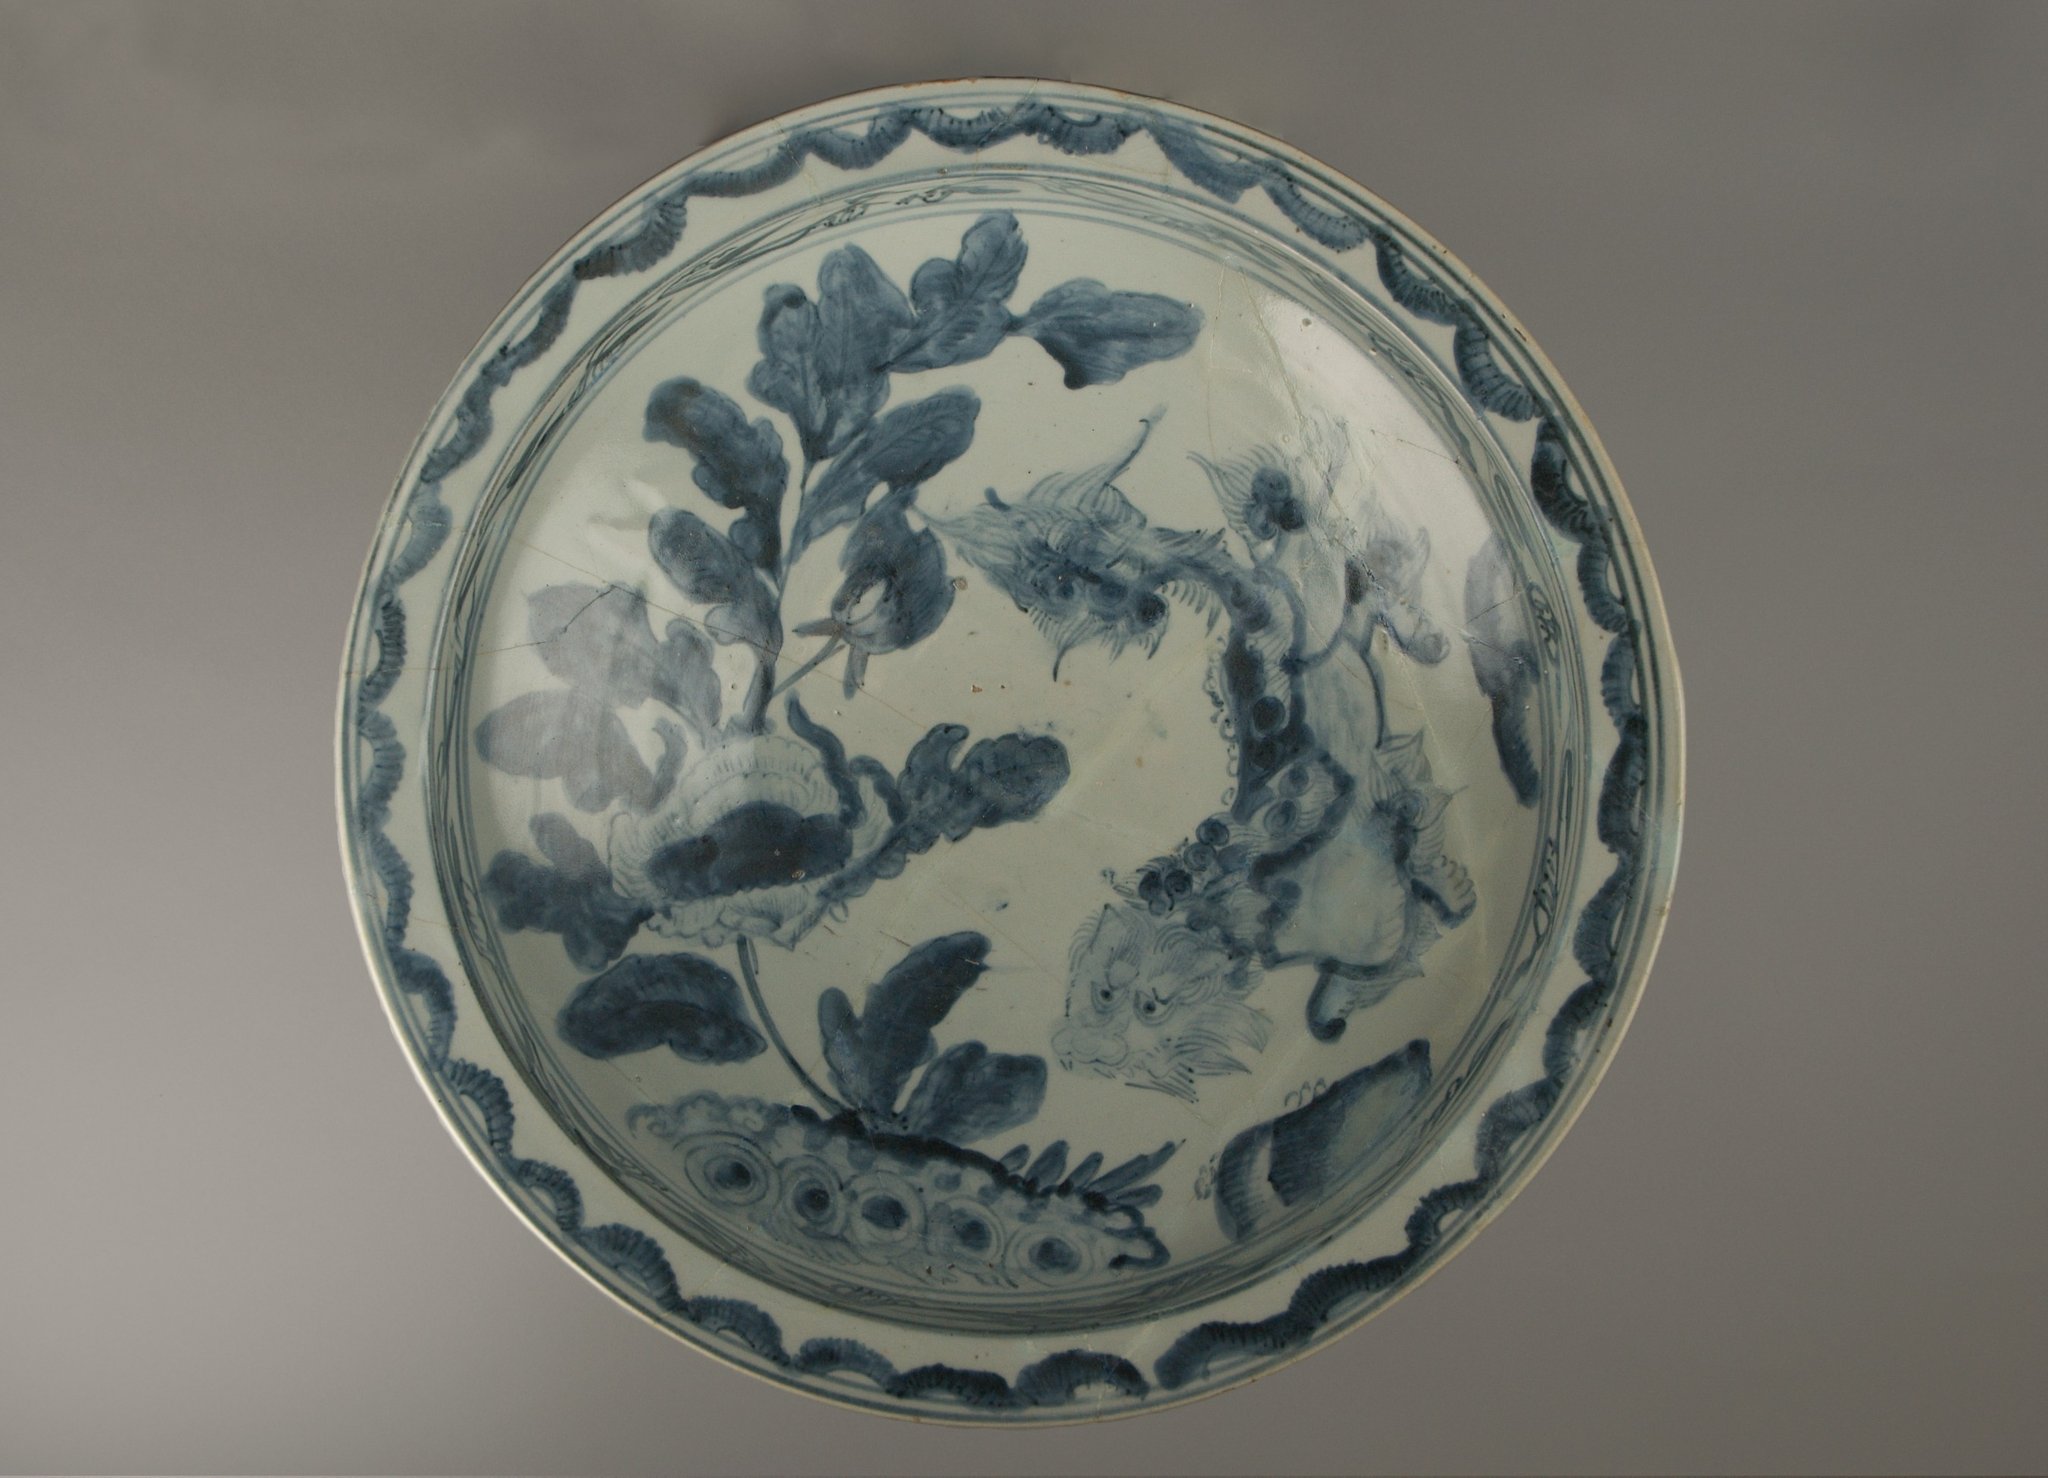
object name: plate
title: Plate with Lion Design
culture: japanese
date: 1615-1868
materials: porcelain, stoneware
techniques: underglaze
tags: insects,lions